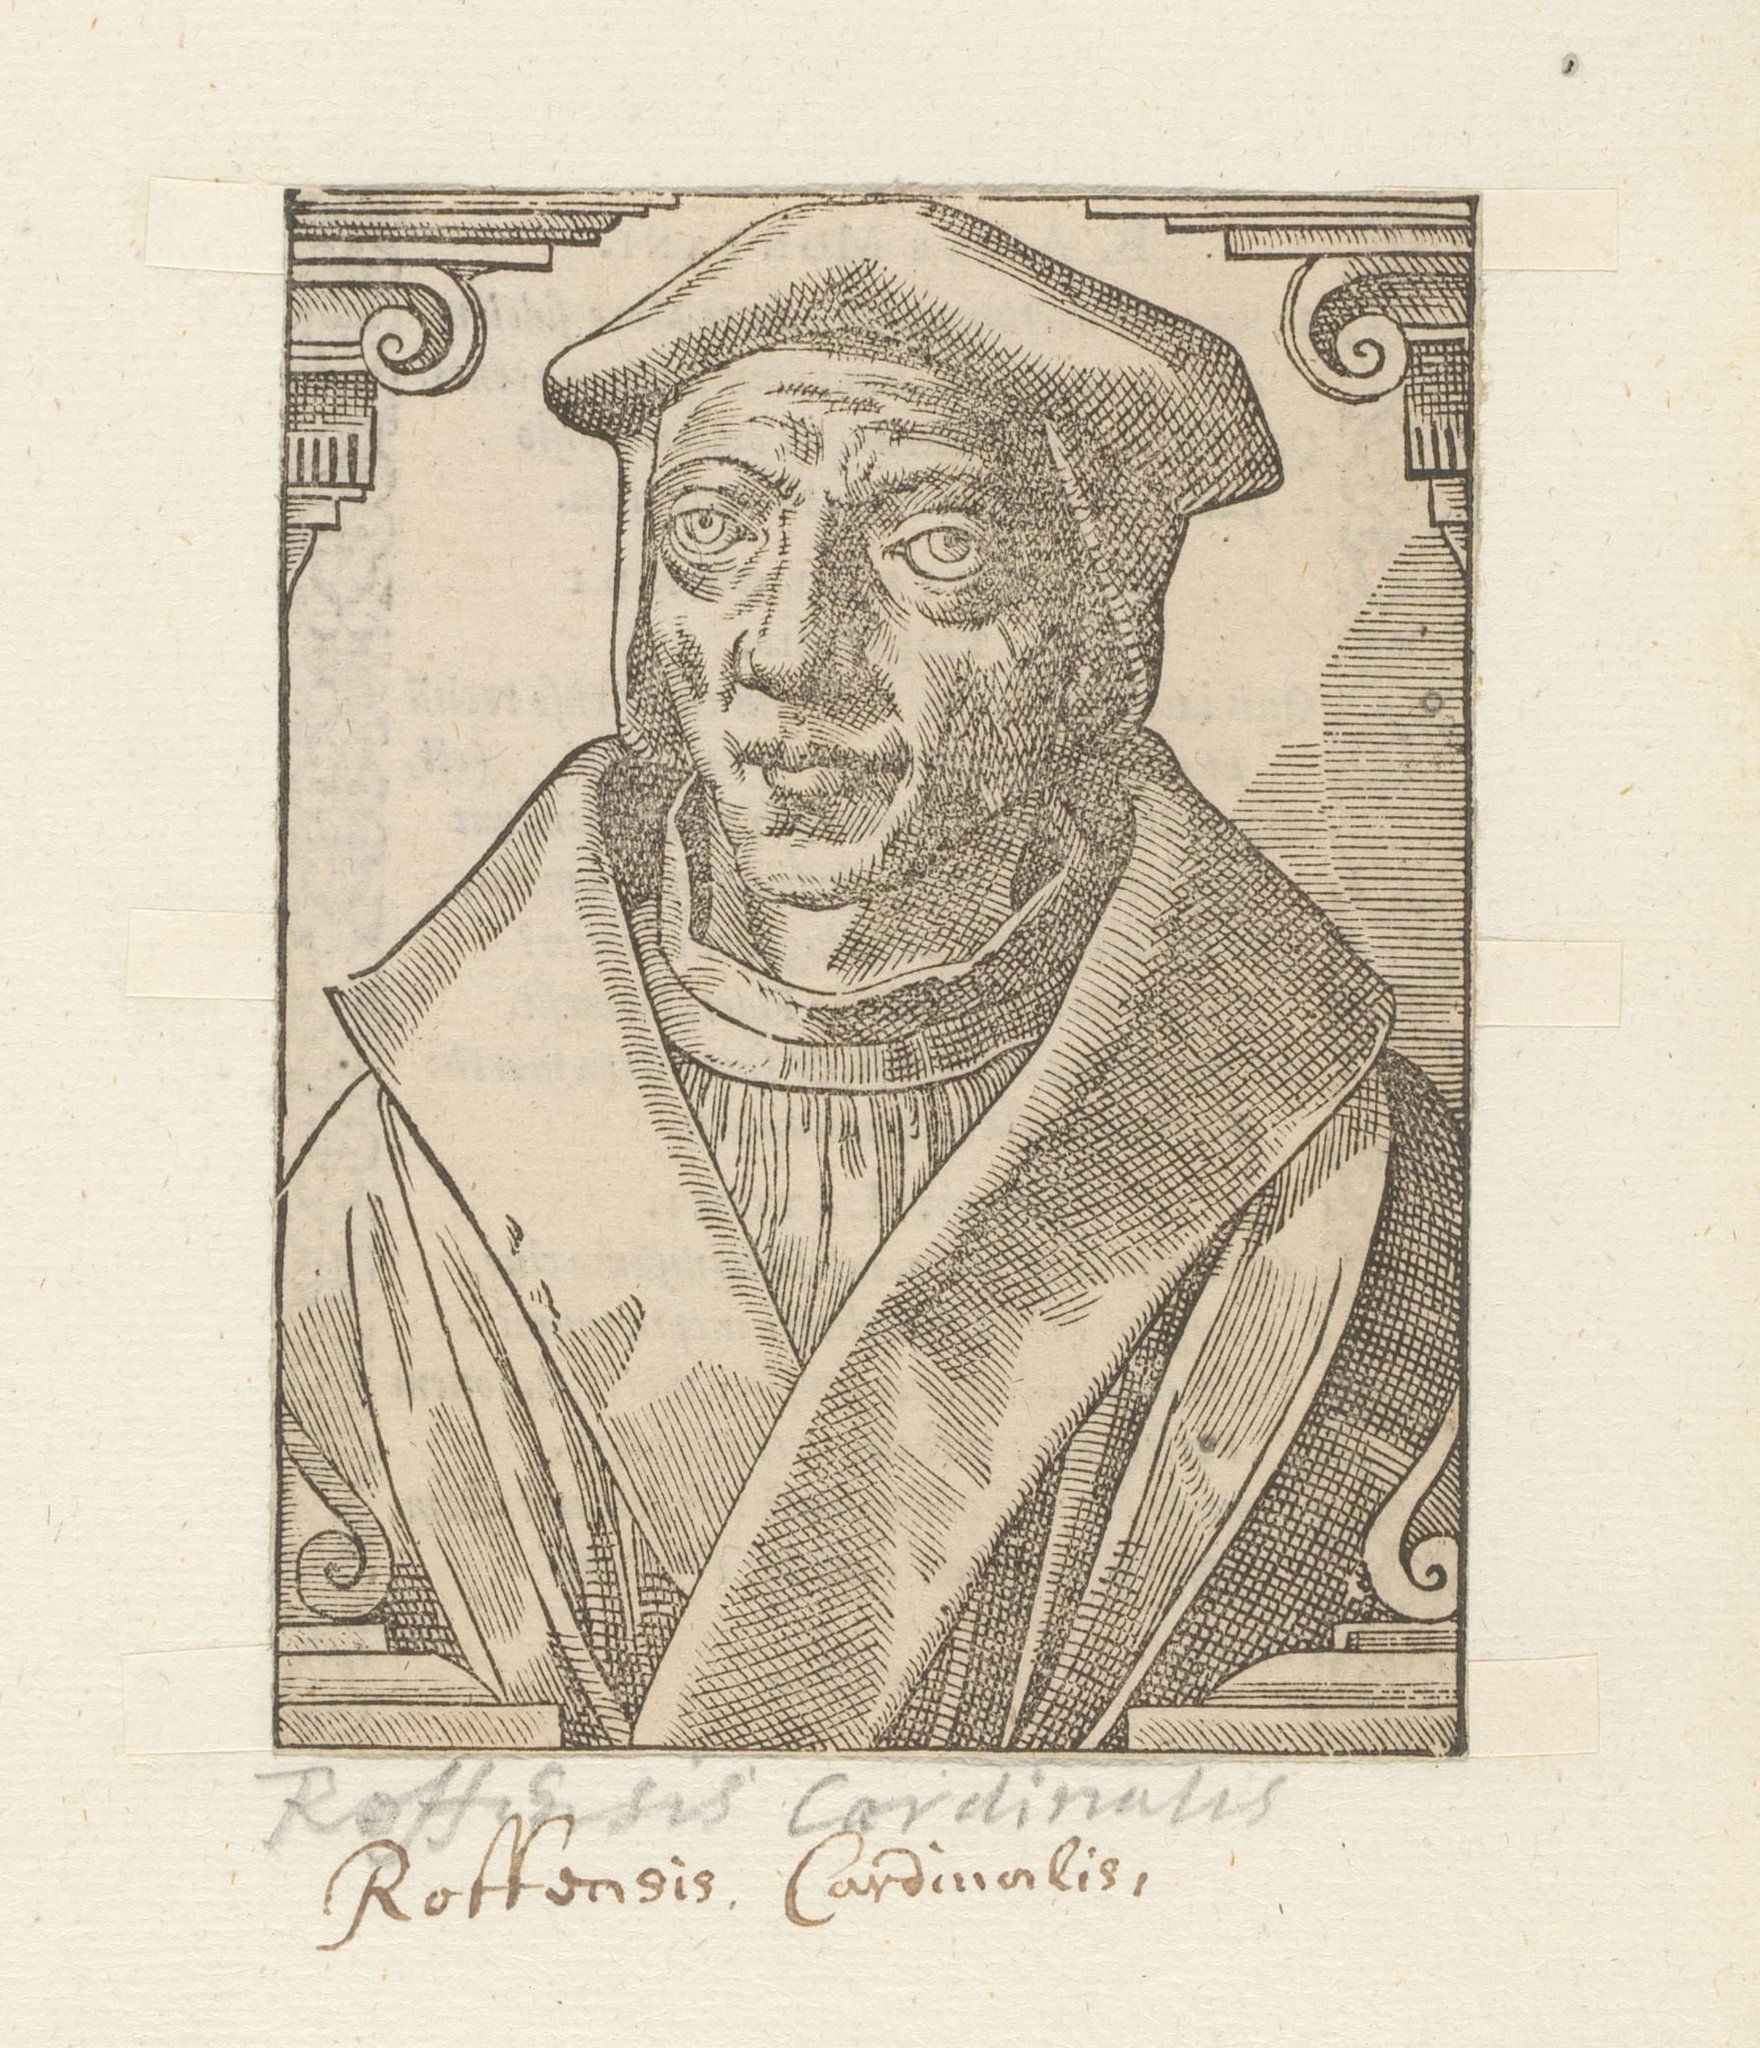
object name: book illustration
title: Portret van John Fisher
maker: Anonymous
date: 1549-1577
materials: paper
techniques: letterpress printing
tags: london, archbishop, bishop, etc. (roman catholic), historical persons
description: Prent gebruikt in: Giovio, Paolo. Elogia Virorum literis illustrium (...). Bazel: Peter Perna, 1577.